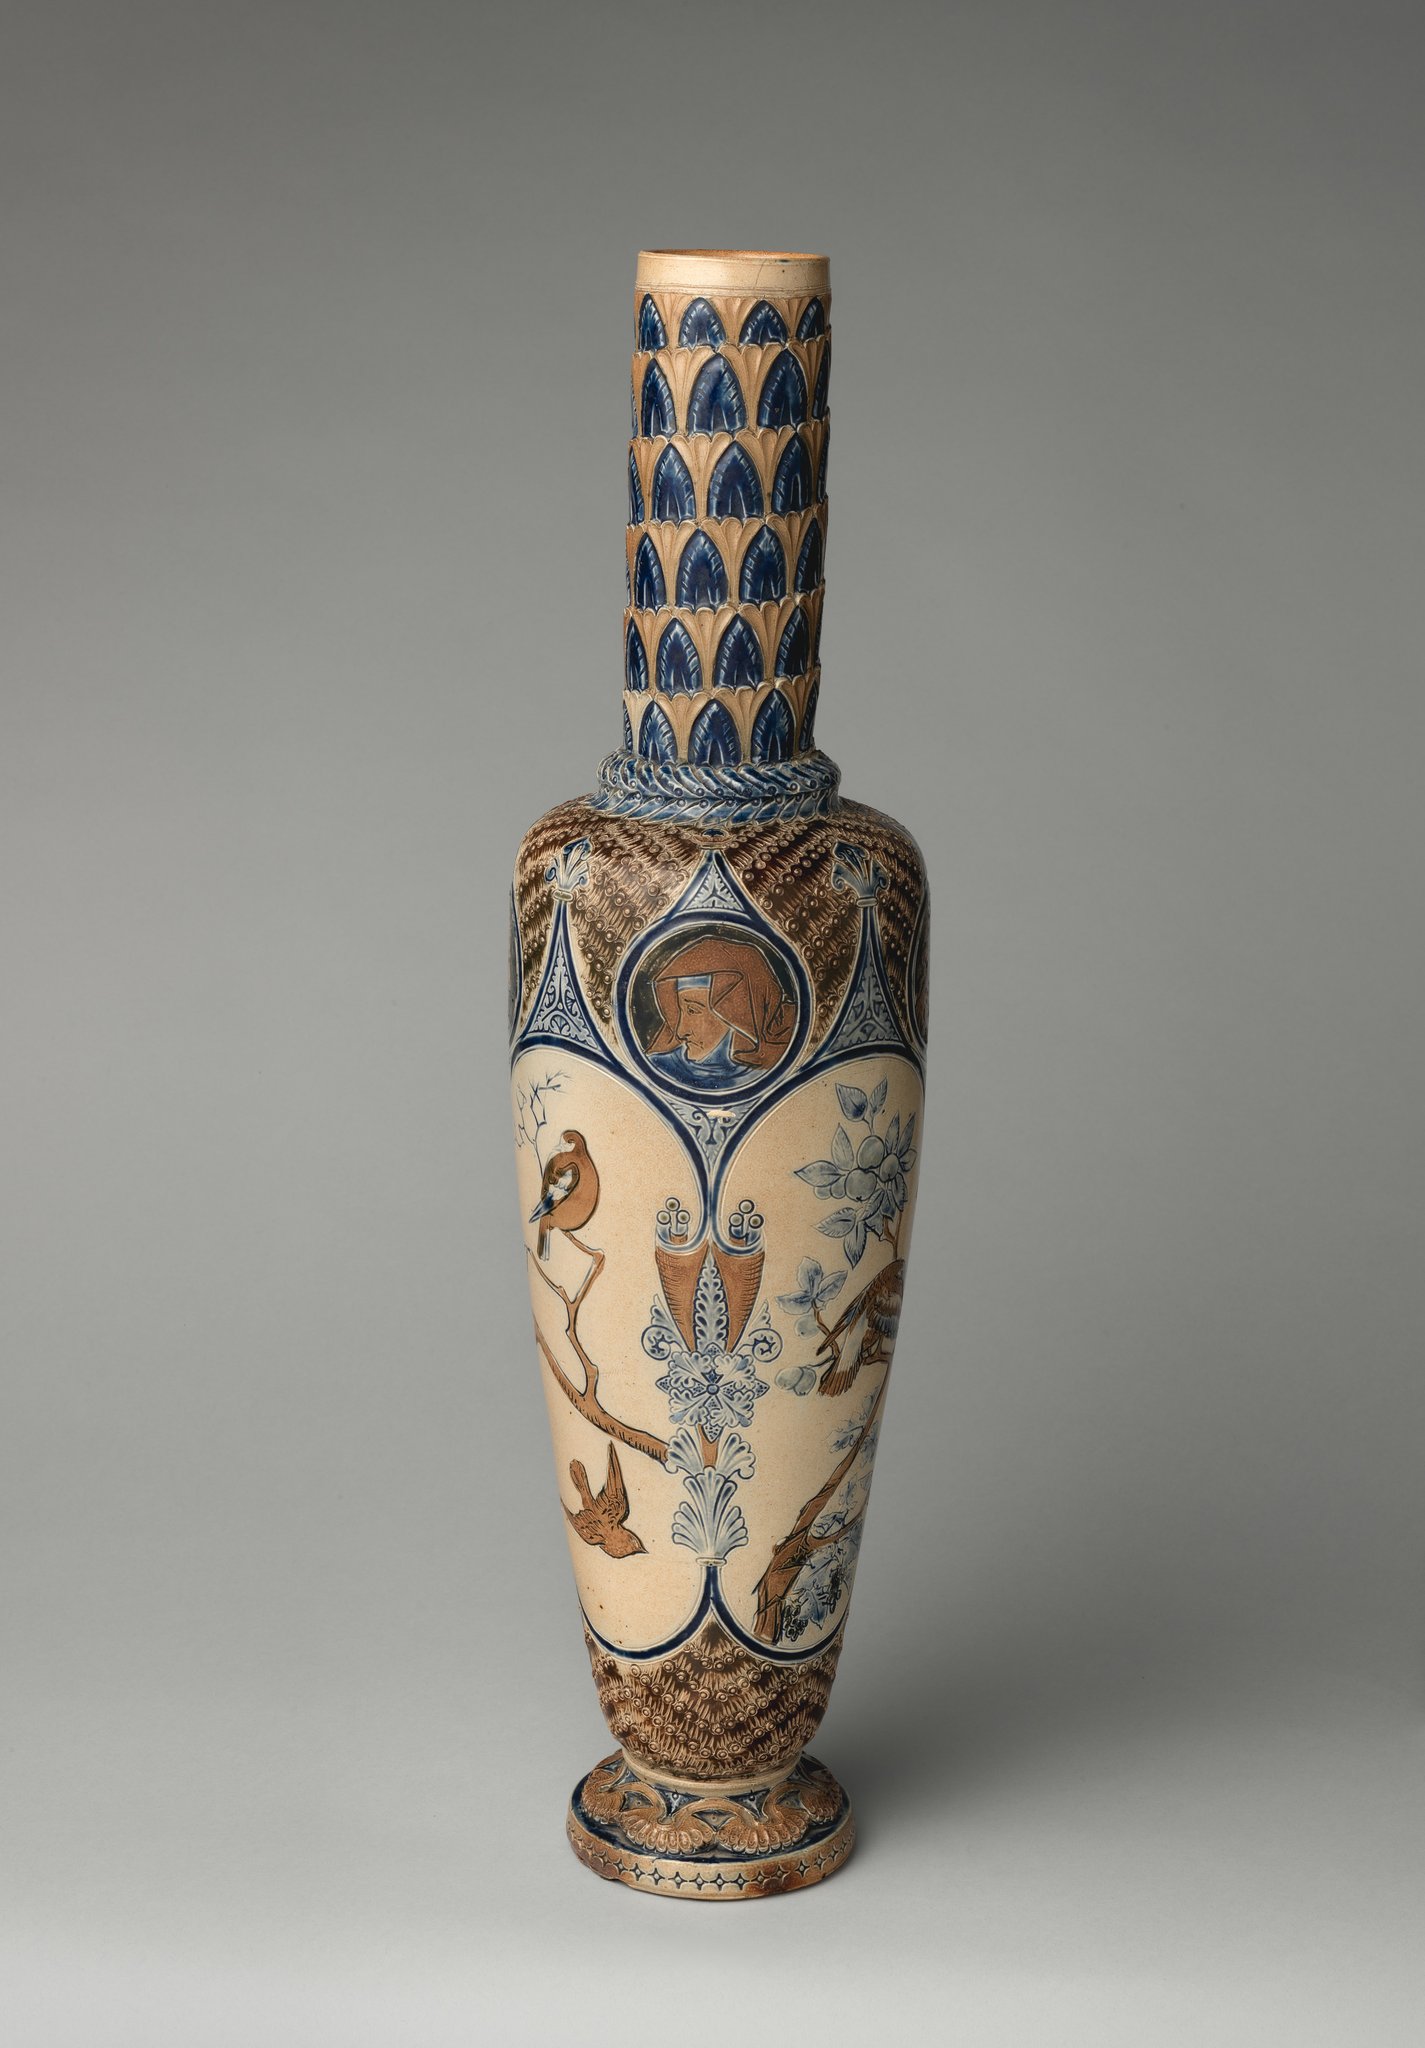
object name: vase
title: Vase with birds and portrait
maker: r. w. martin and brothers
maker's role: maker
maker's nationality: british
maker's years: 1873-1915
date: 1876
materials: stoneware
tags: birds,profiles